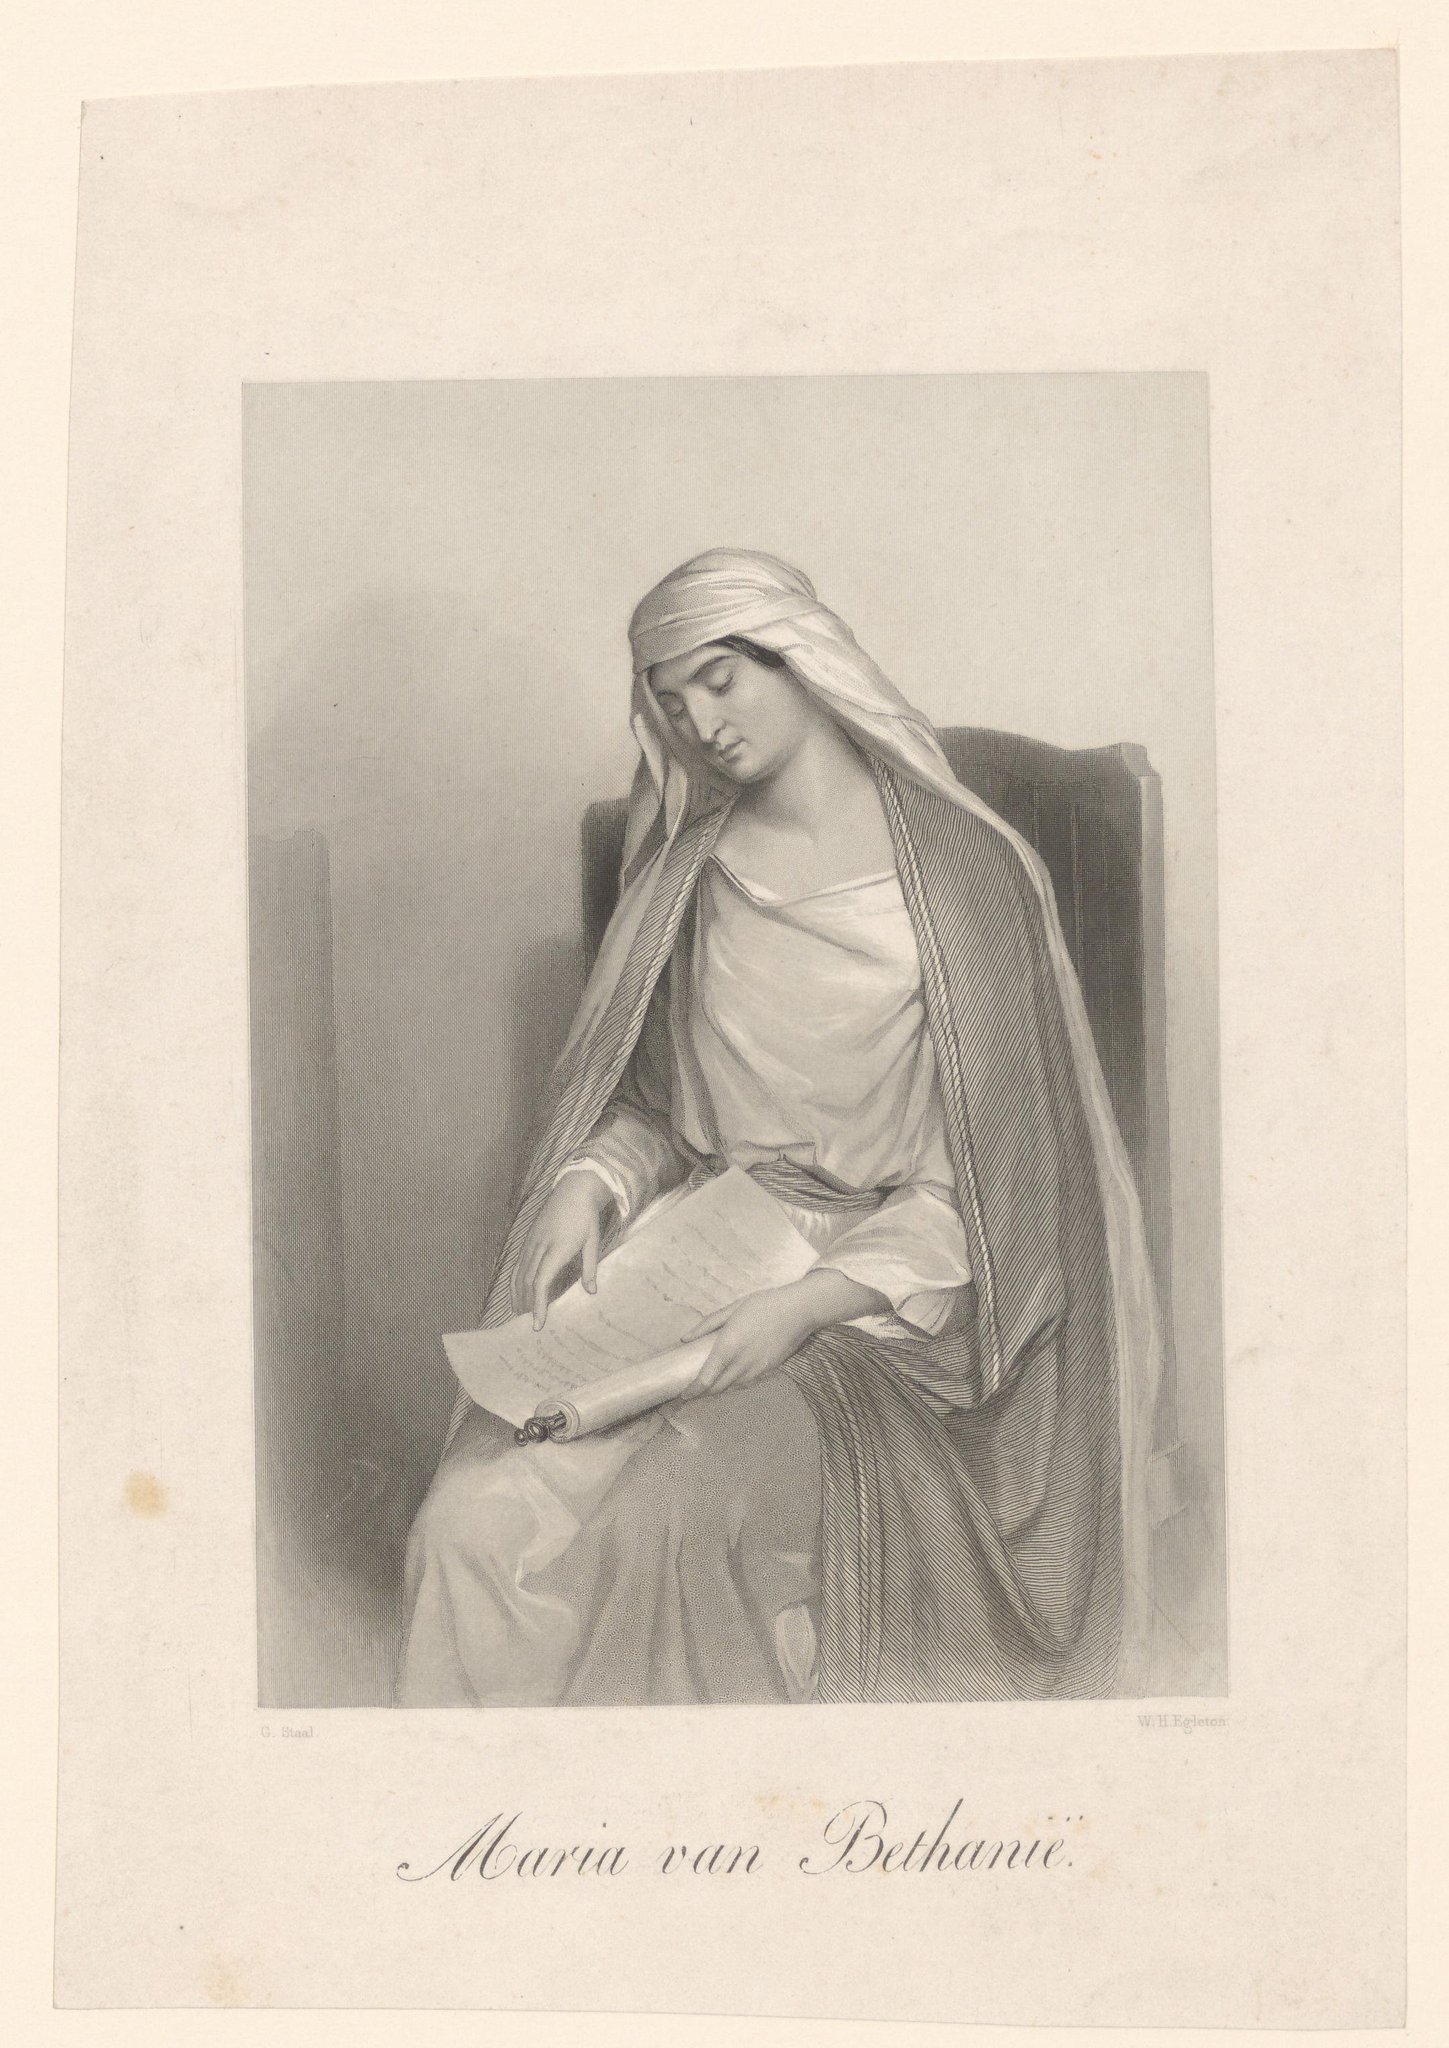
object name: print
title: Maria van Bethanië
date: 1833-1862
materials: paper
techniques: etching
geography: london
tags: reading, female saints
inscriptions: collector's mark: Lugt 2228